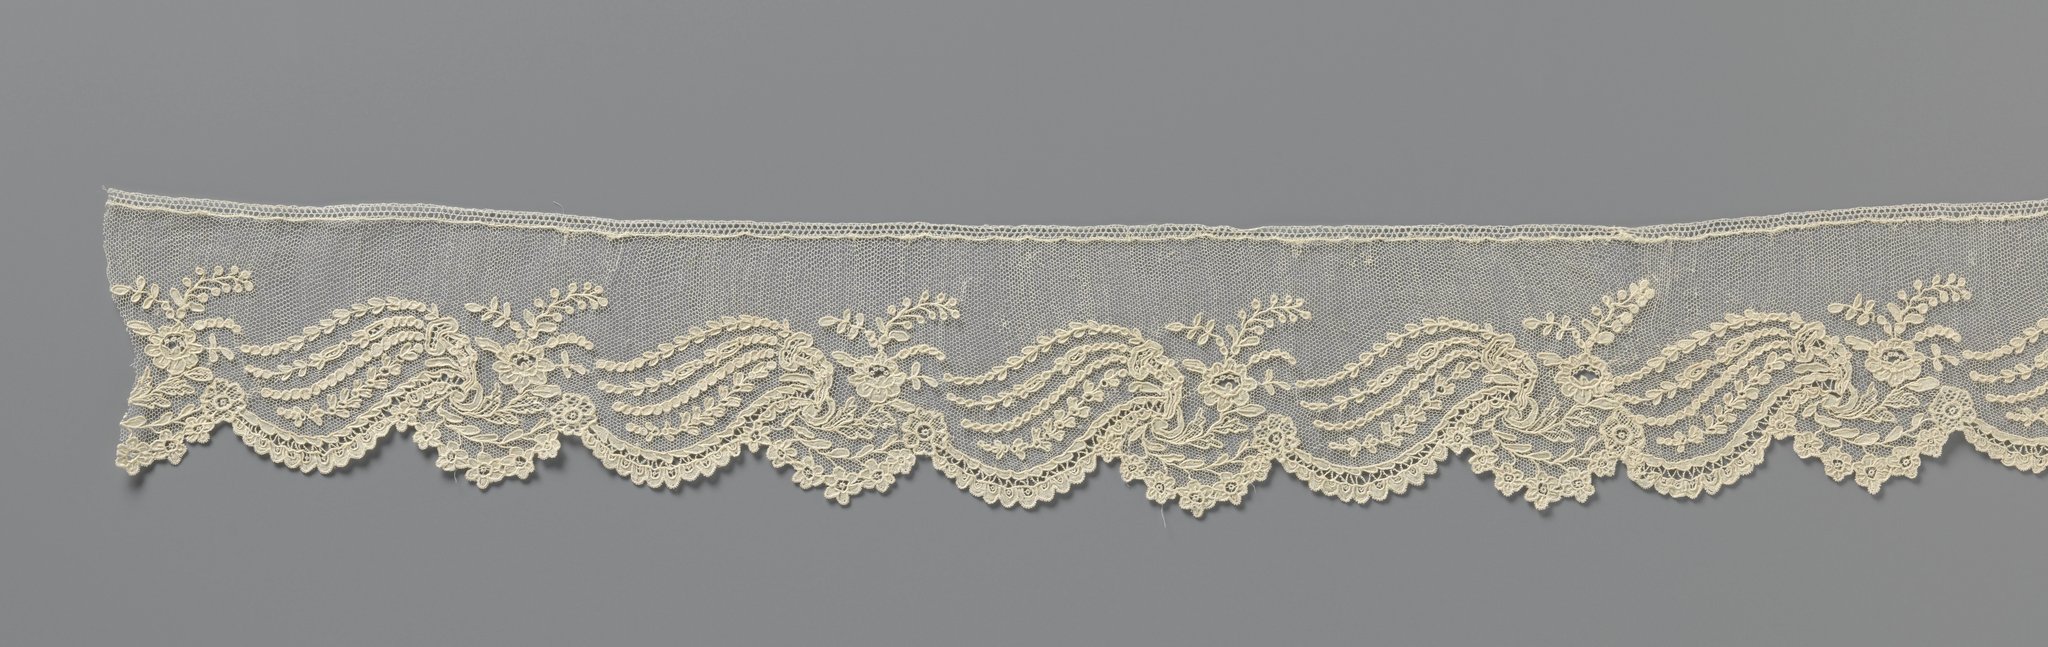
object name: strip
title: Strook naaldkant met rozentak en vier bladslingers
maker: Anonymous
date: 1900-1909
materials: linen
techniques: lace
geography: france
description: Strook naturelkleurige naaldkant: Alençon-kant. Patroon met een repetitief motief van een rozentak en vier bladslingers op een fijne zeshoekige maasgrond. De vier slingers, allen met verschillende blaadjes, golven vanuit één punt dezelfde richting uit. Regelmatige bogen met schulpjes langs de onderzijde worden gevormd door afwisselend een slinger en een aaneenschakeling van rozetbloemen, steeds met elkaar verbonden door één grotere rozetbloem. In het centrum van de slinger een zigzaglijn van gepicoteerde spijlen. De bovenzijde is afgezet met een rand kloskant.